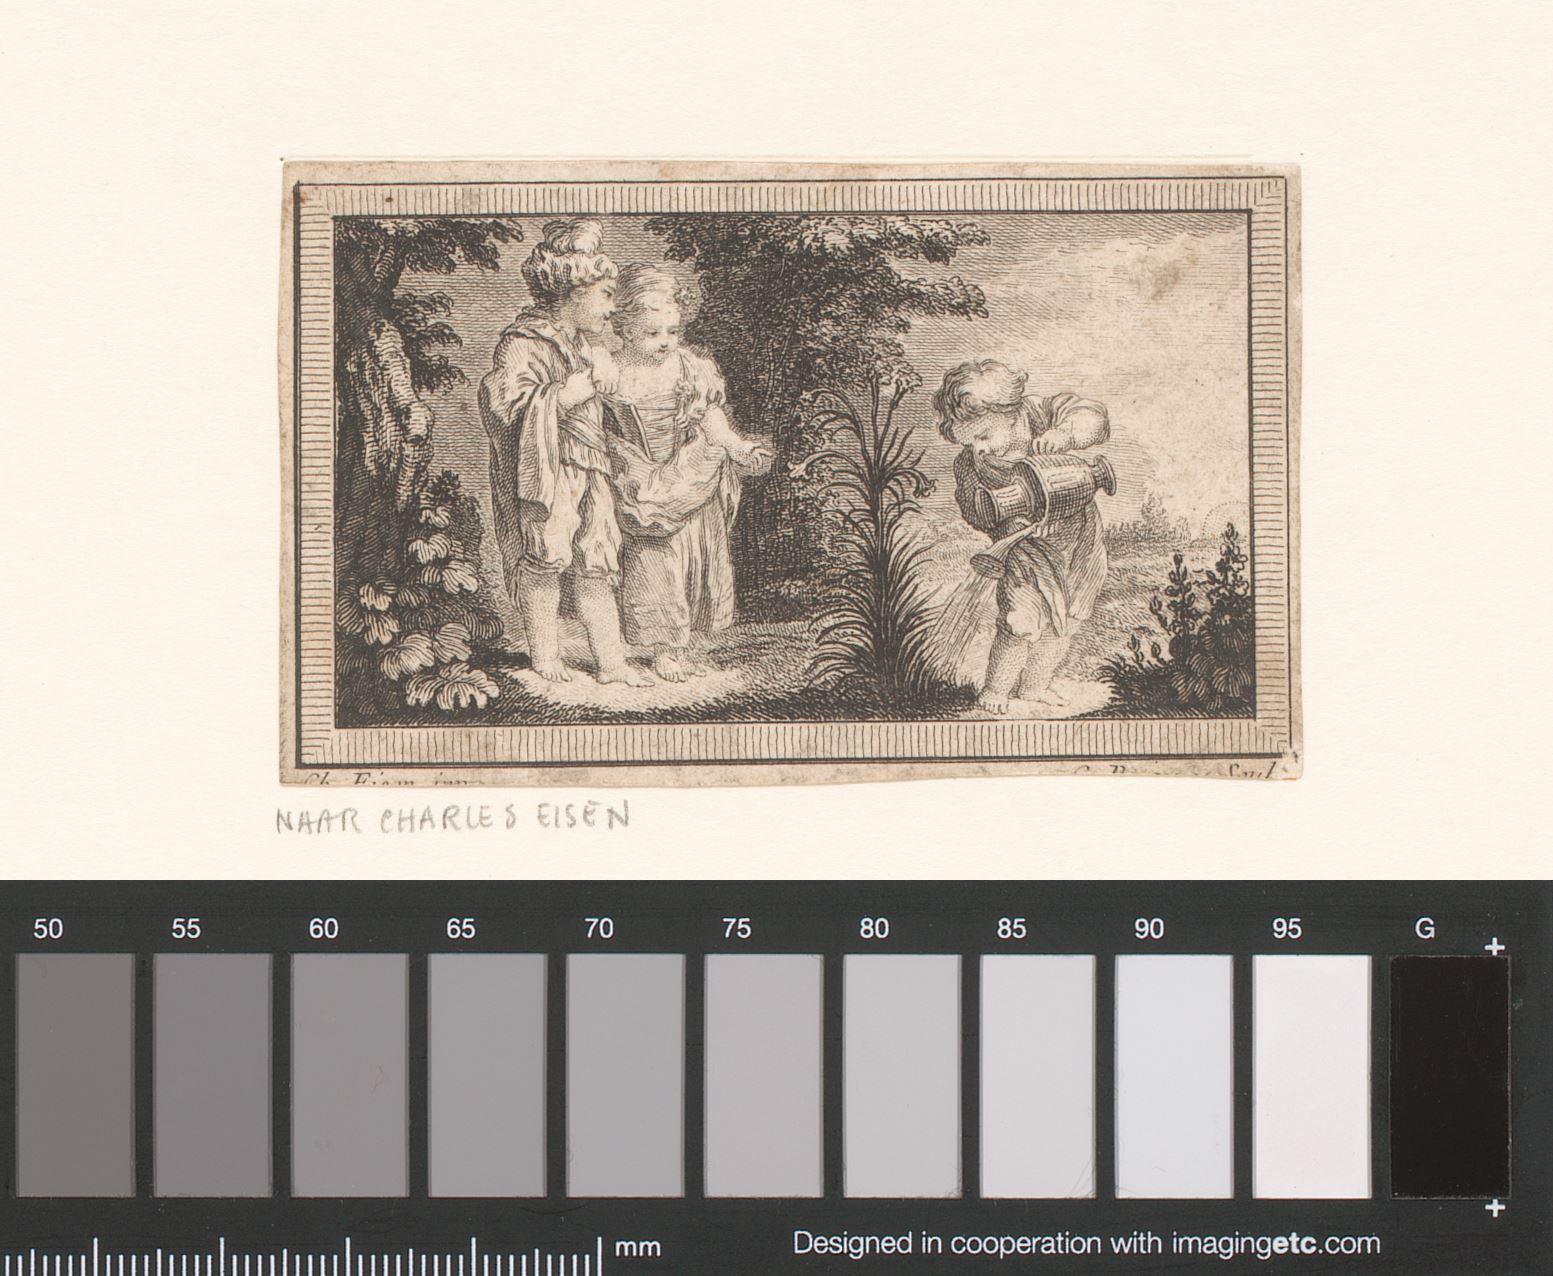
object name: print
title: Drie kinderen in een tuin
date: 1730-1783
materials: paper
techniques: engraving, etching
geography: paris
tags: child, watering plants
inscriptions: collector's mark: Lugt 2228